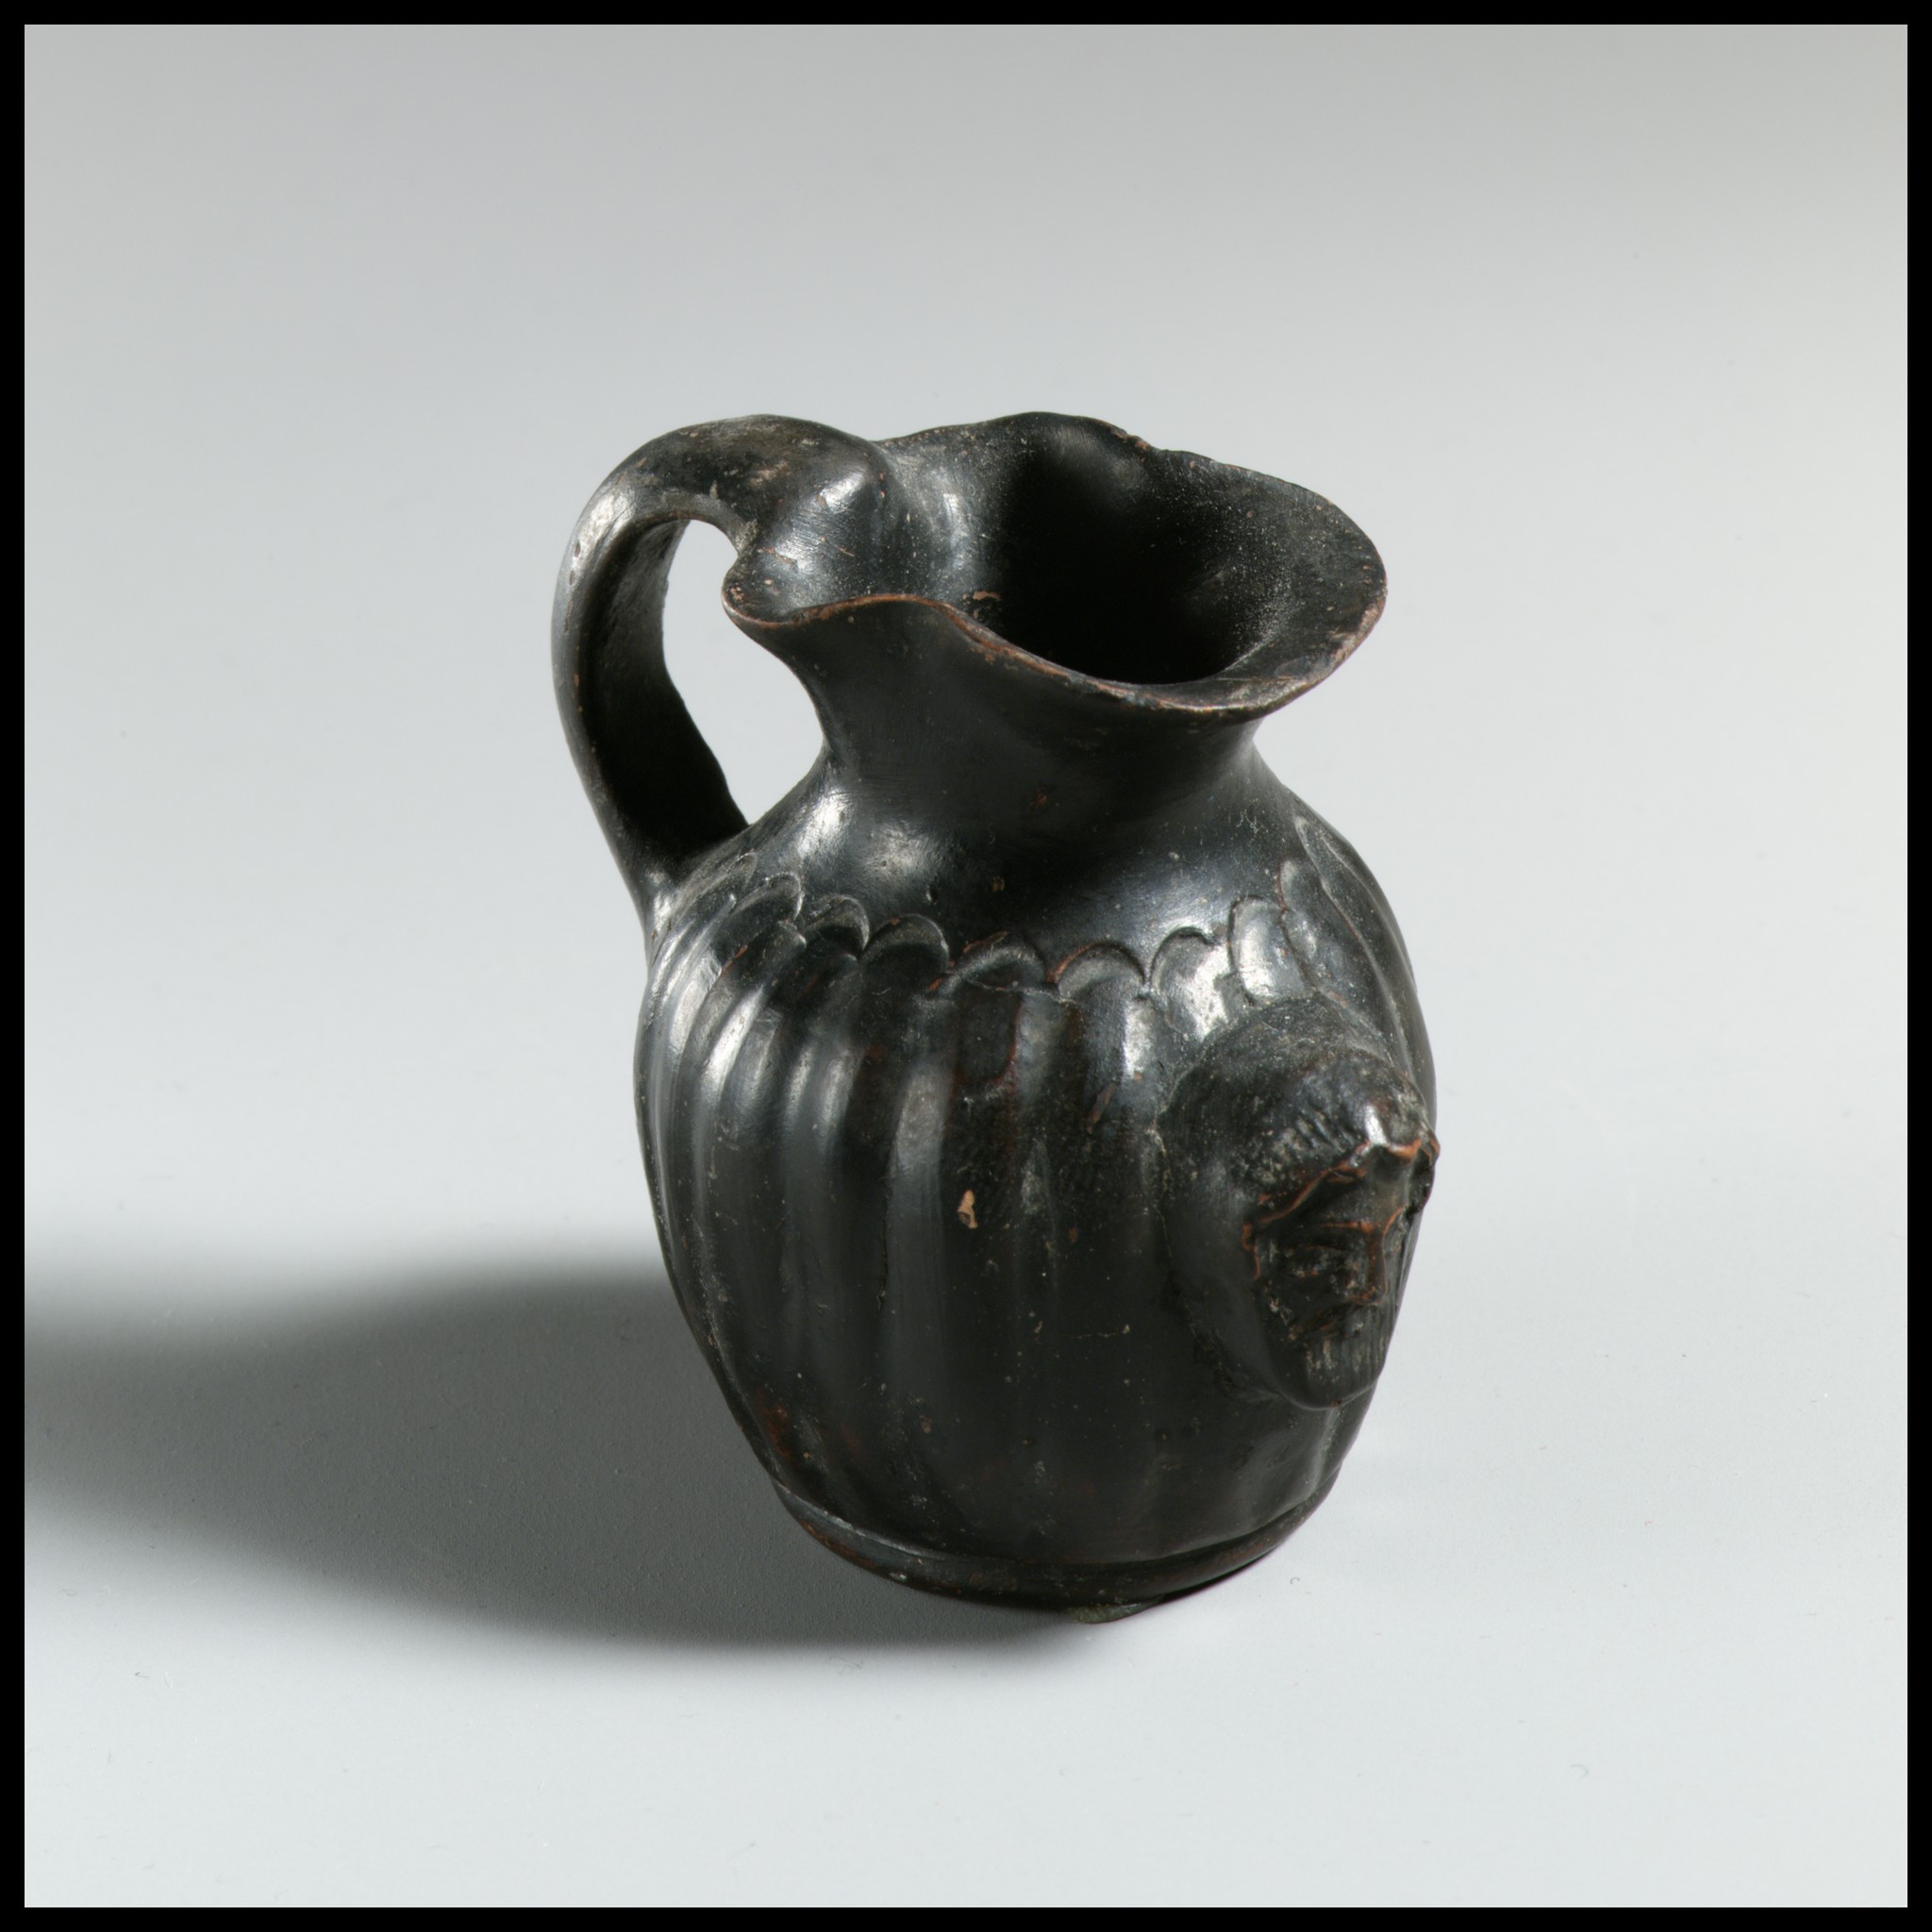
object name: oinochoe, miniature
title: Terracotta miniature oinochoe (jug)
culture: greek or south italian or campanian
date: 400-301 BCE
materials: terracotta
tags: men